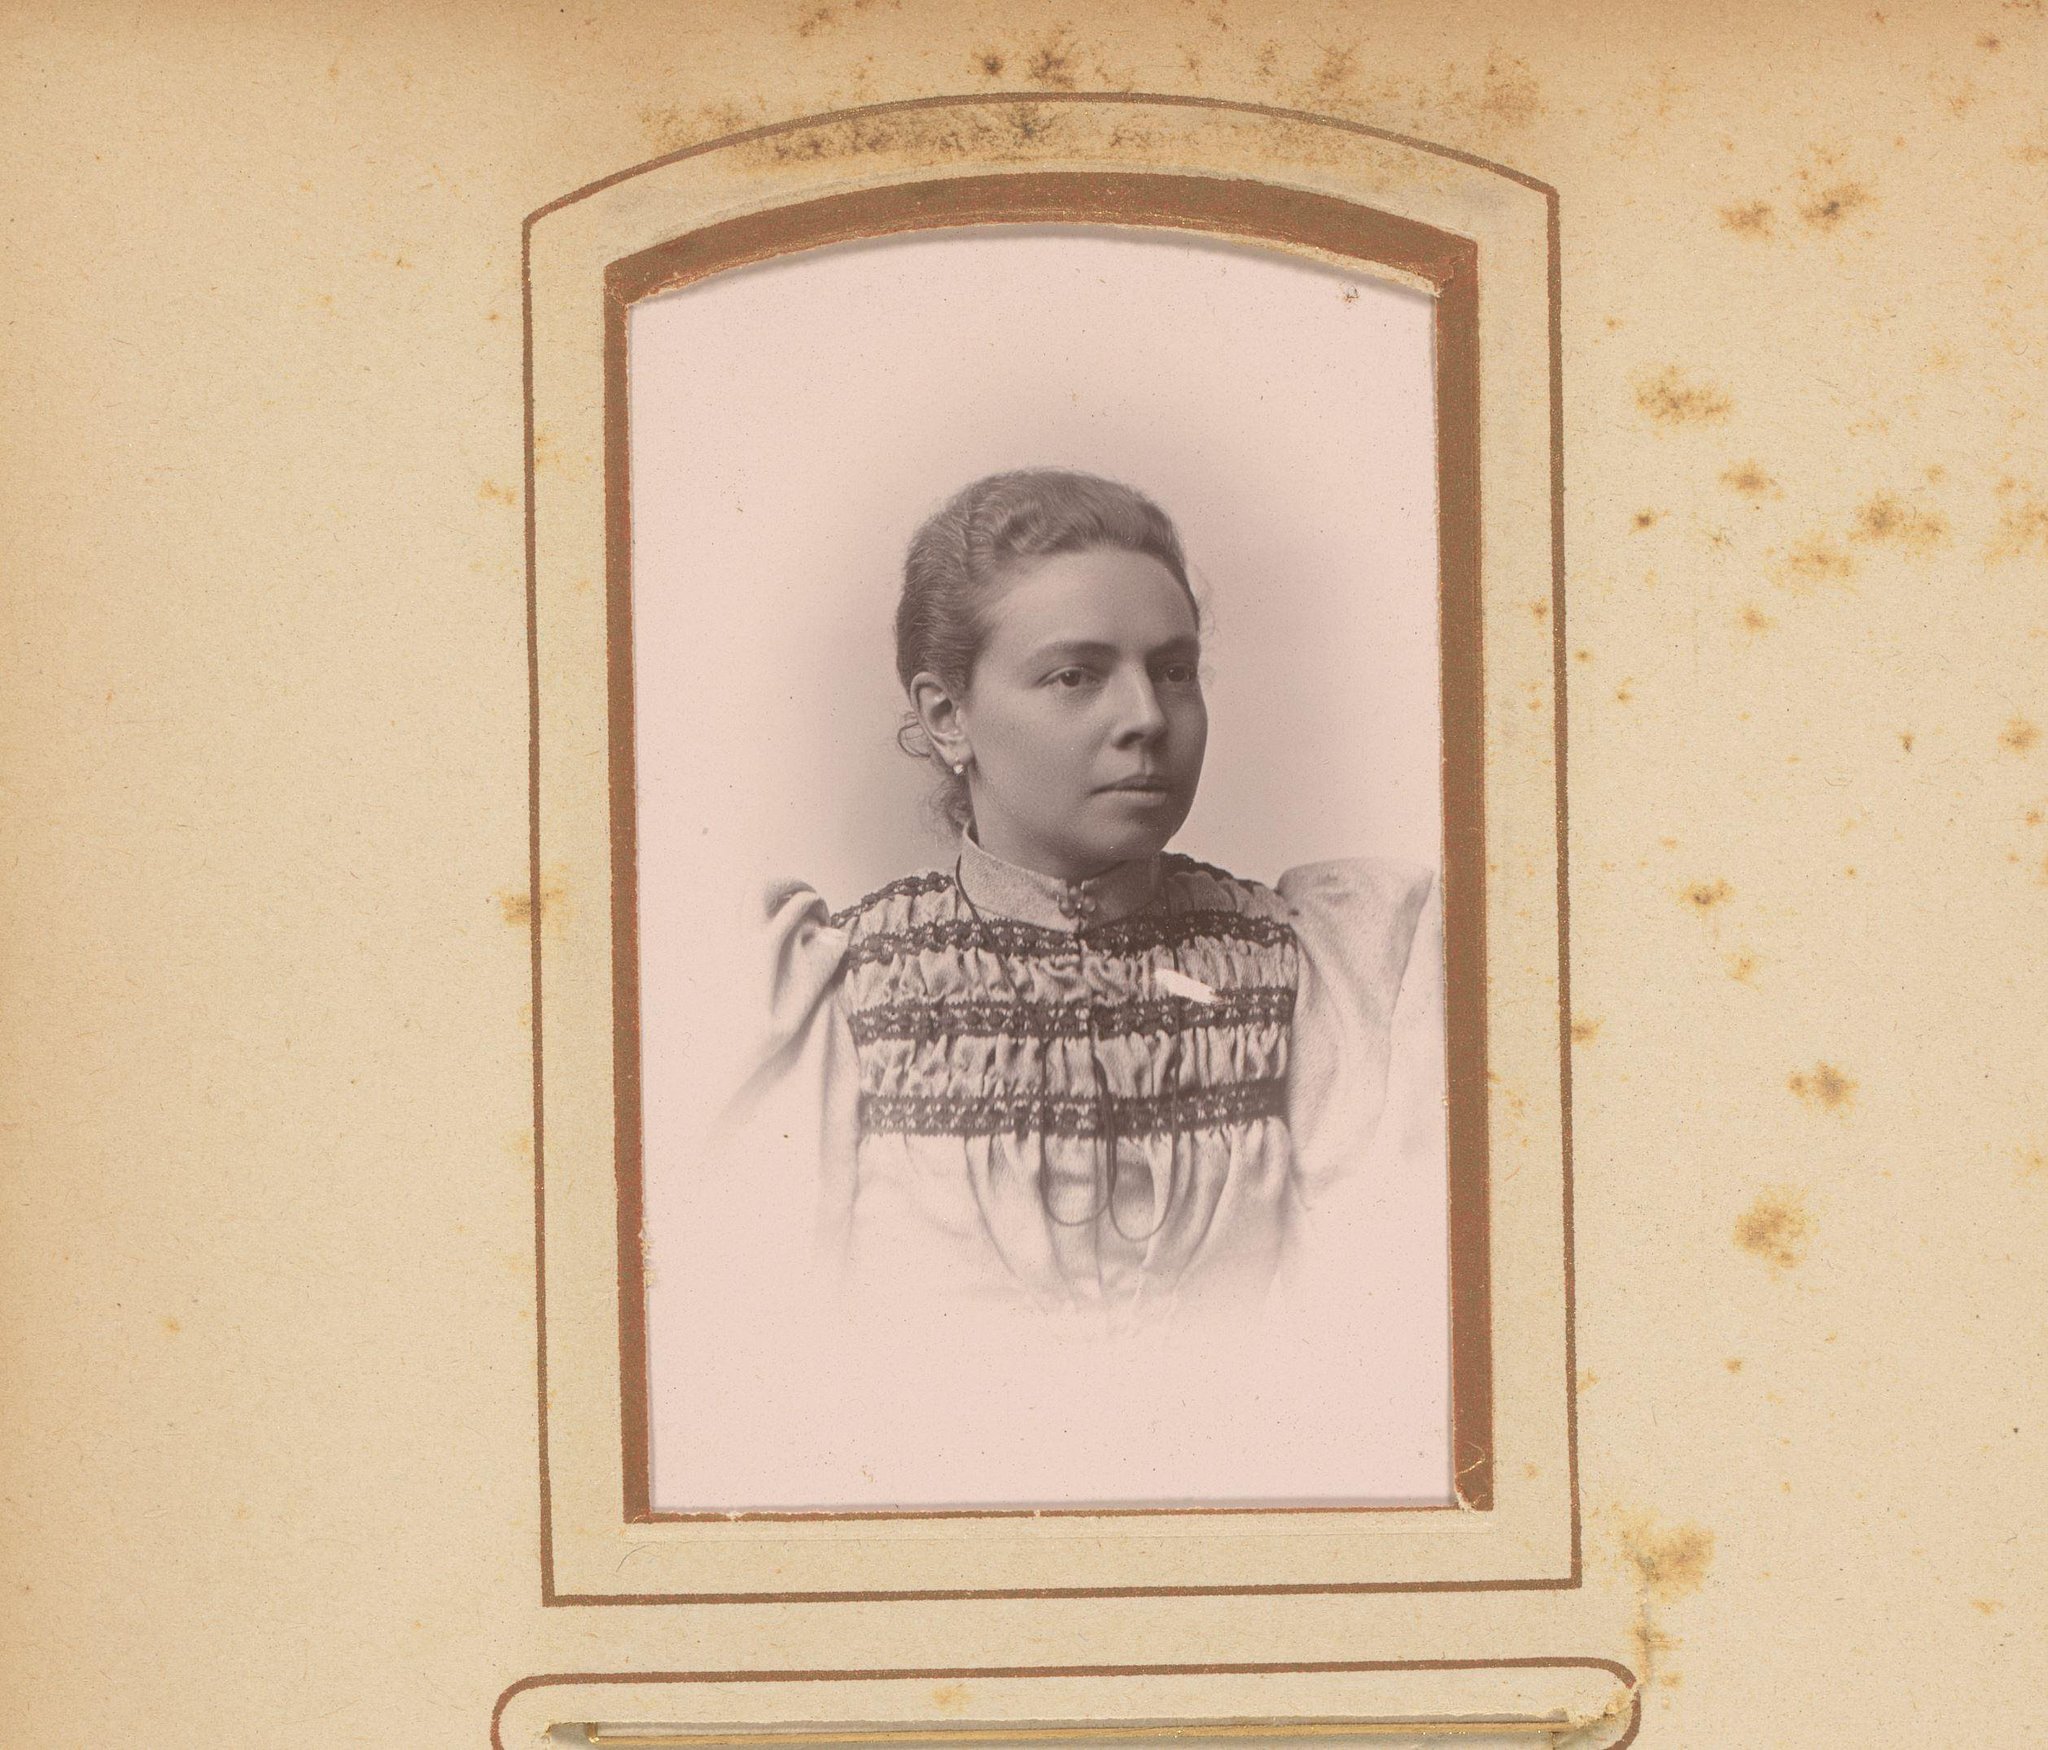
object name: album leaf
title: Portret van een jonge vrouw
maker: carl wilhelm bauer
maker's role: fotograaf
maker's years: 1844-1911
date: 1880-1908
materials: cardboard, photographic support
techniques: gelatin silver print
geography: middelburg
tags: adolescent, young woman, maiden, historical persons - bb - woman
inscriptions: inscription: ‘C.W. Bauer/ Photograaf/ Middelburg, St. Janstraat H 202’, inscription: ‘C.W. Bauer/ Middelburg’, annotation: ‘AV’